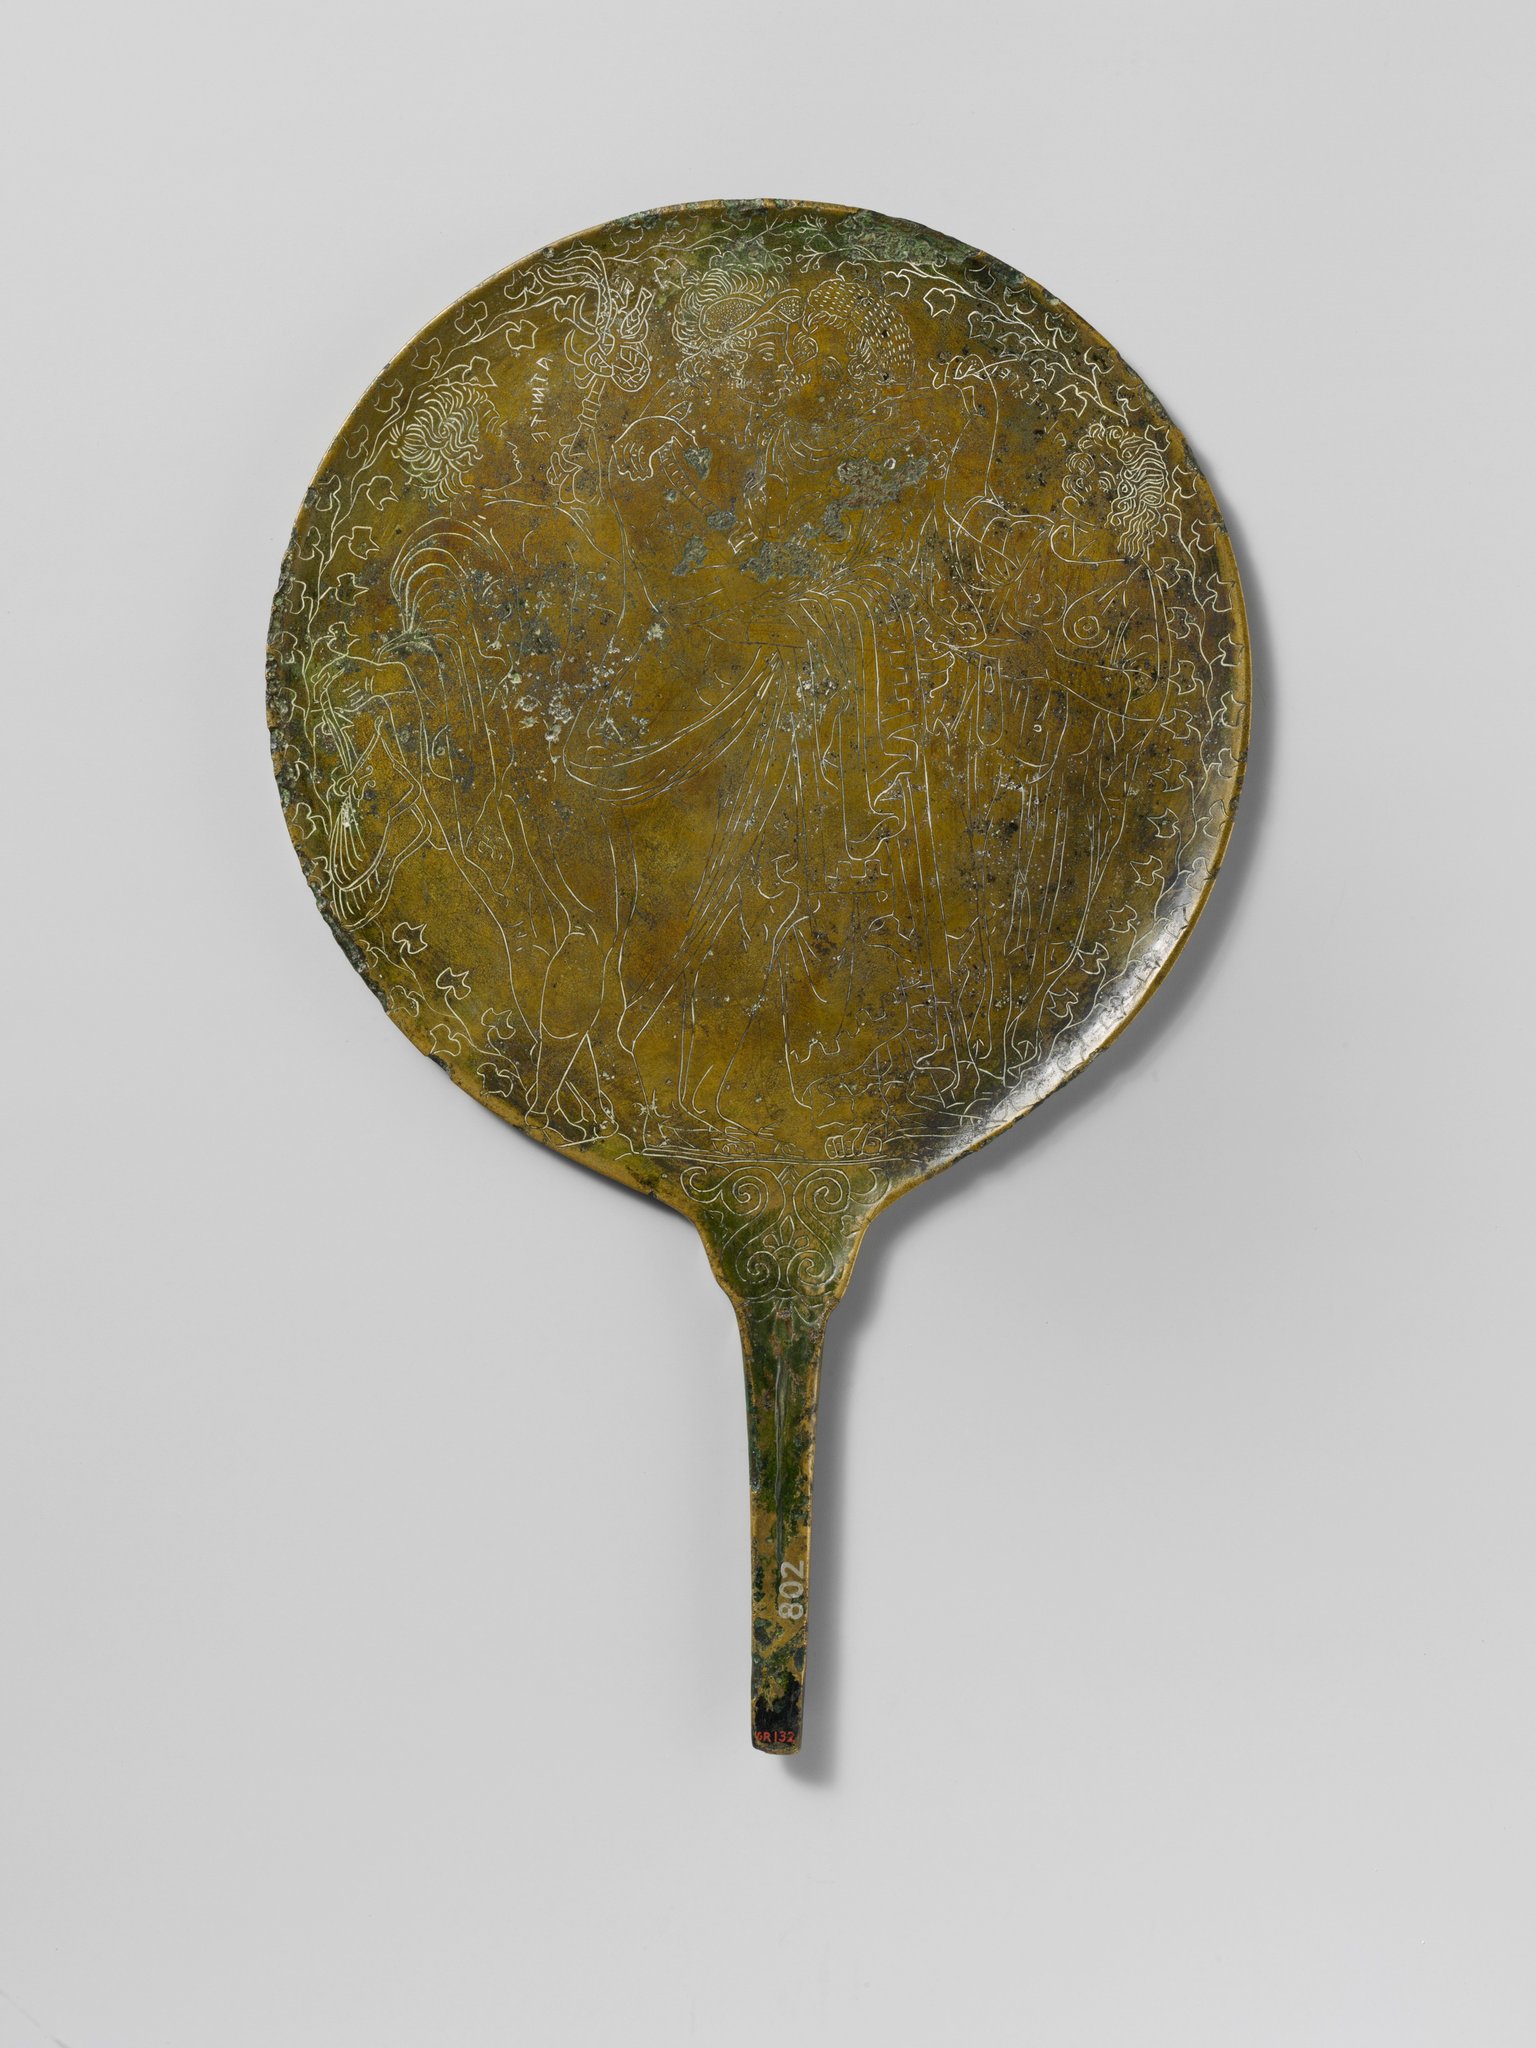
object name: mirror with admetus and alkestis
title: Bronze mirror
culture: etruscan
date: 400-350 BCE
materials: bronze